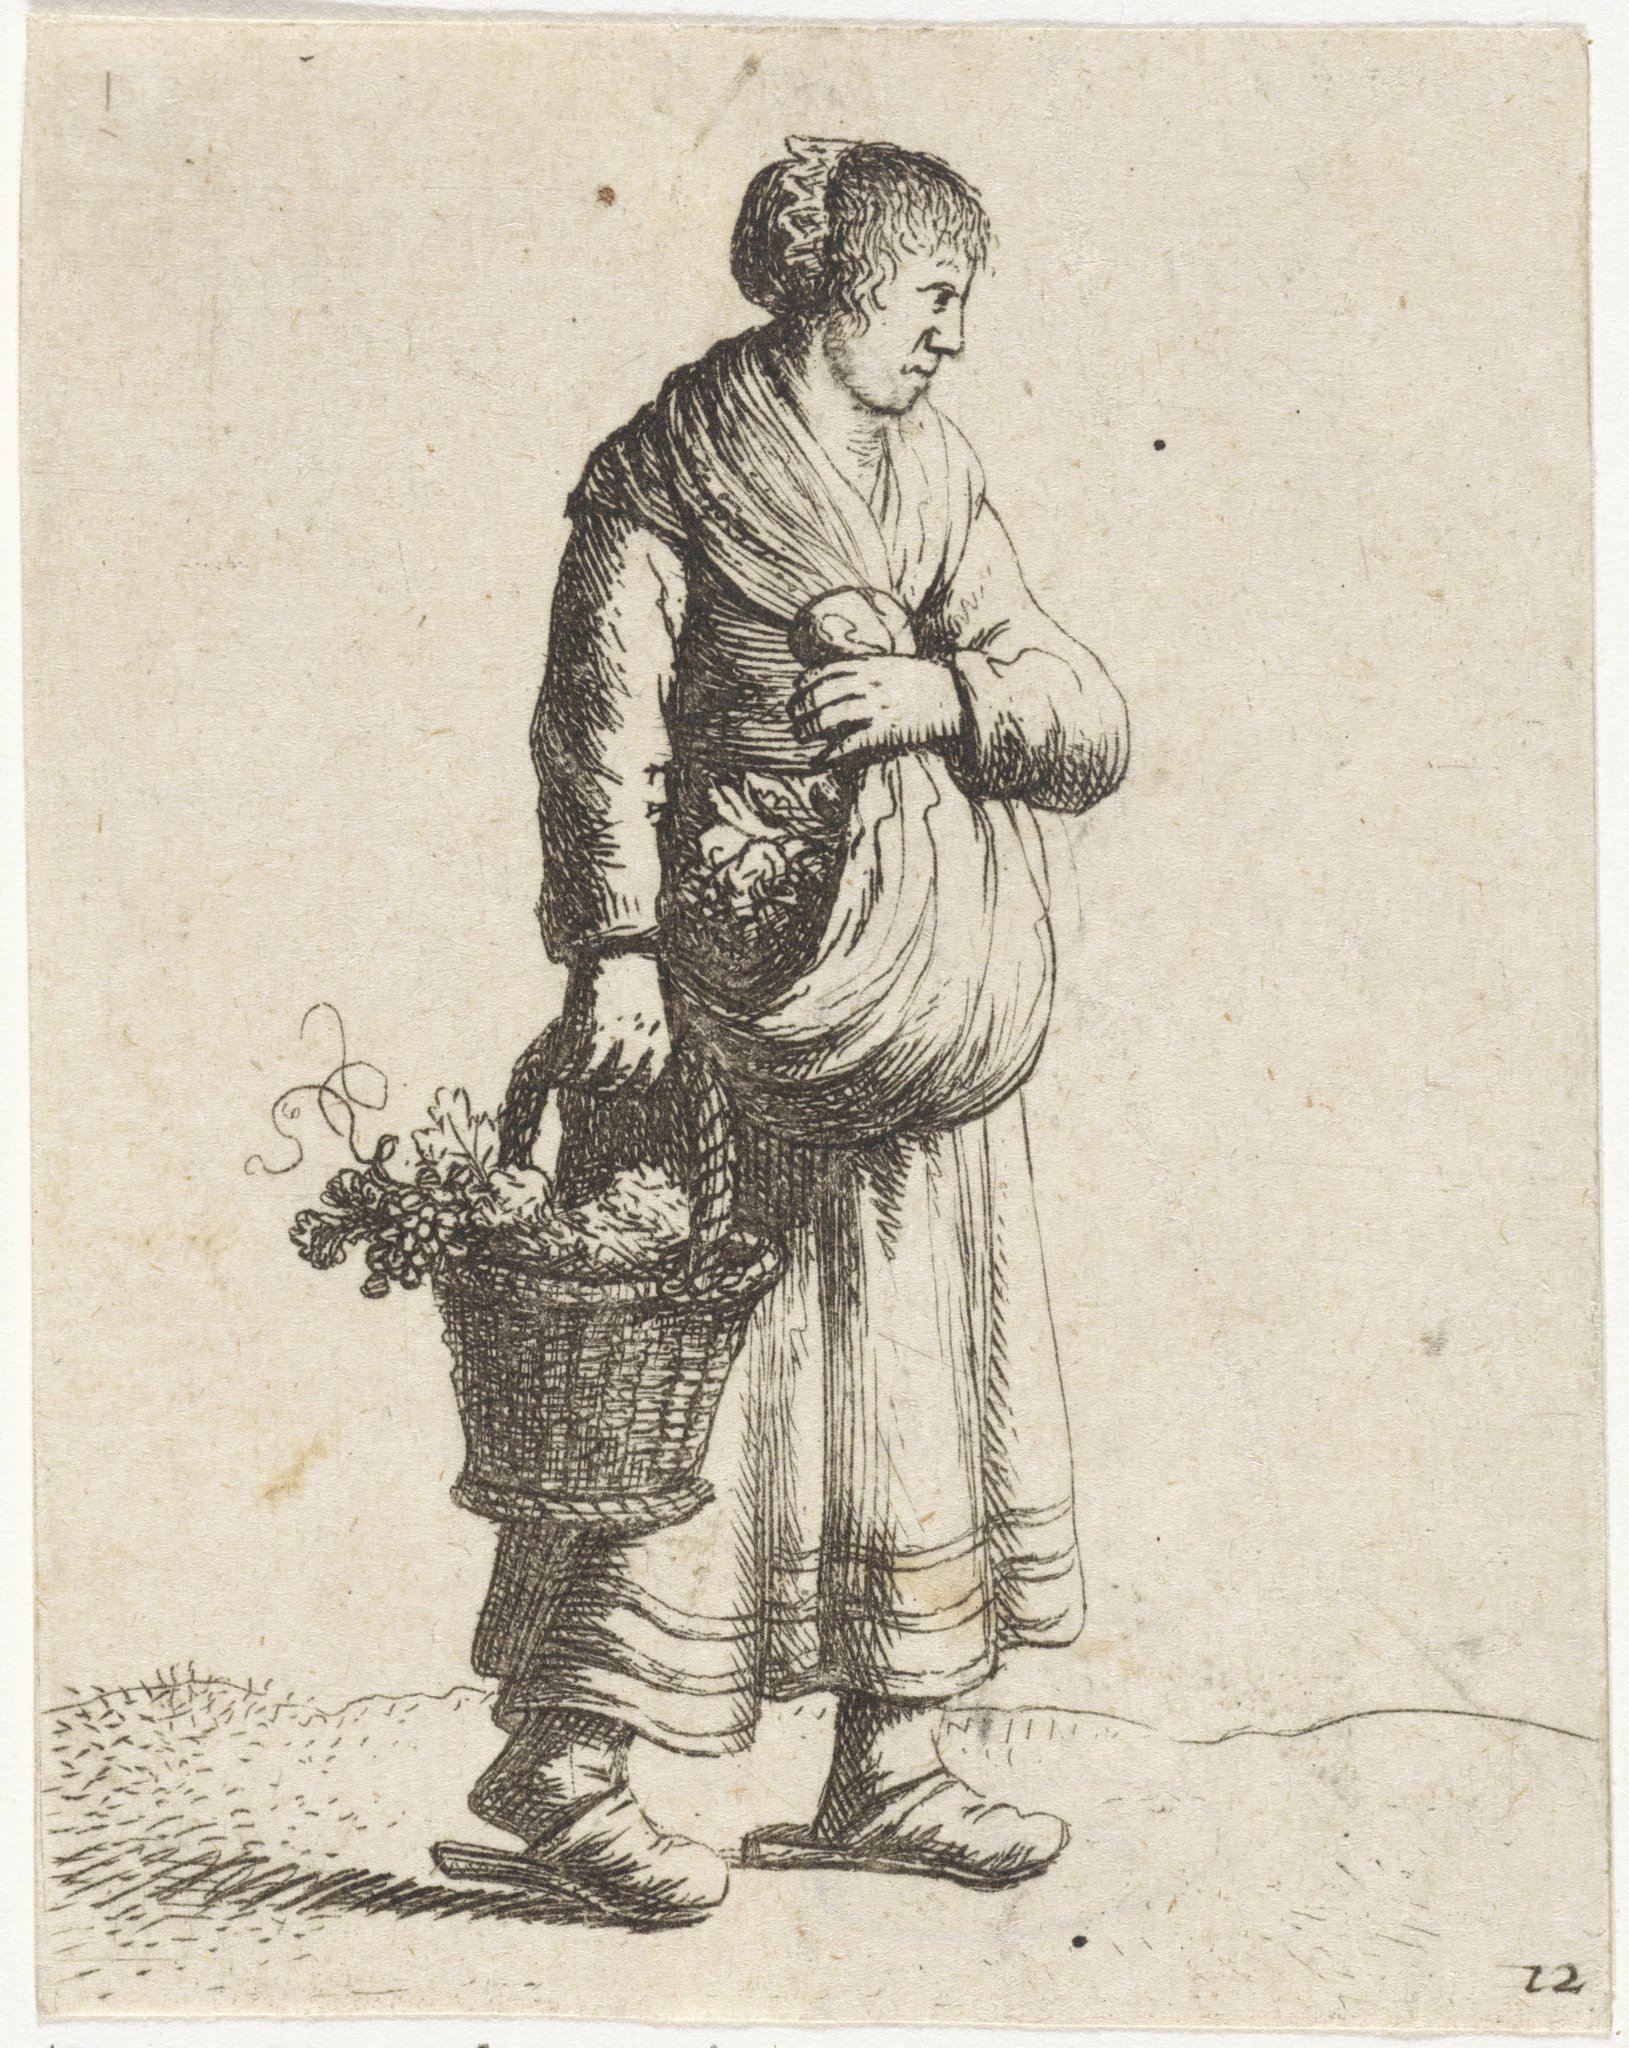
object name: print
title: Staande figuren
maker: jan gillisz. van vliet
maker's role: draughtsman, painter, print maker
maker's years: 1600-1668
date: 1635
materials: paper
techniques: etching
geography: leiden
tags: carrying something in basket, bag, rucksack, etc., container made of plant material other than wood: basket, apron (+ women's clothes)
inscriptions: collector's mark: Lugt 2228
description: Een vrouw draagt groente en fruit in een mand en in haar schort dat zij ophoudt met haar linkerhand.